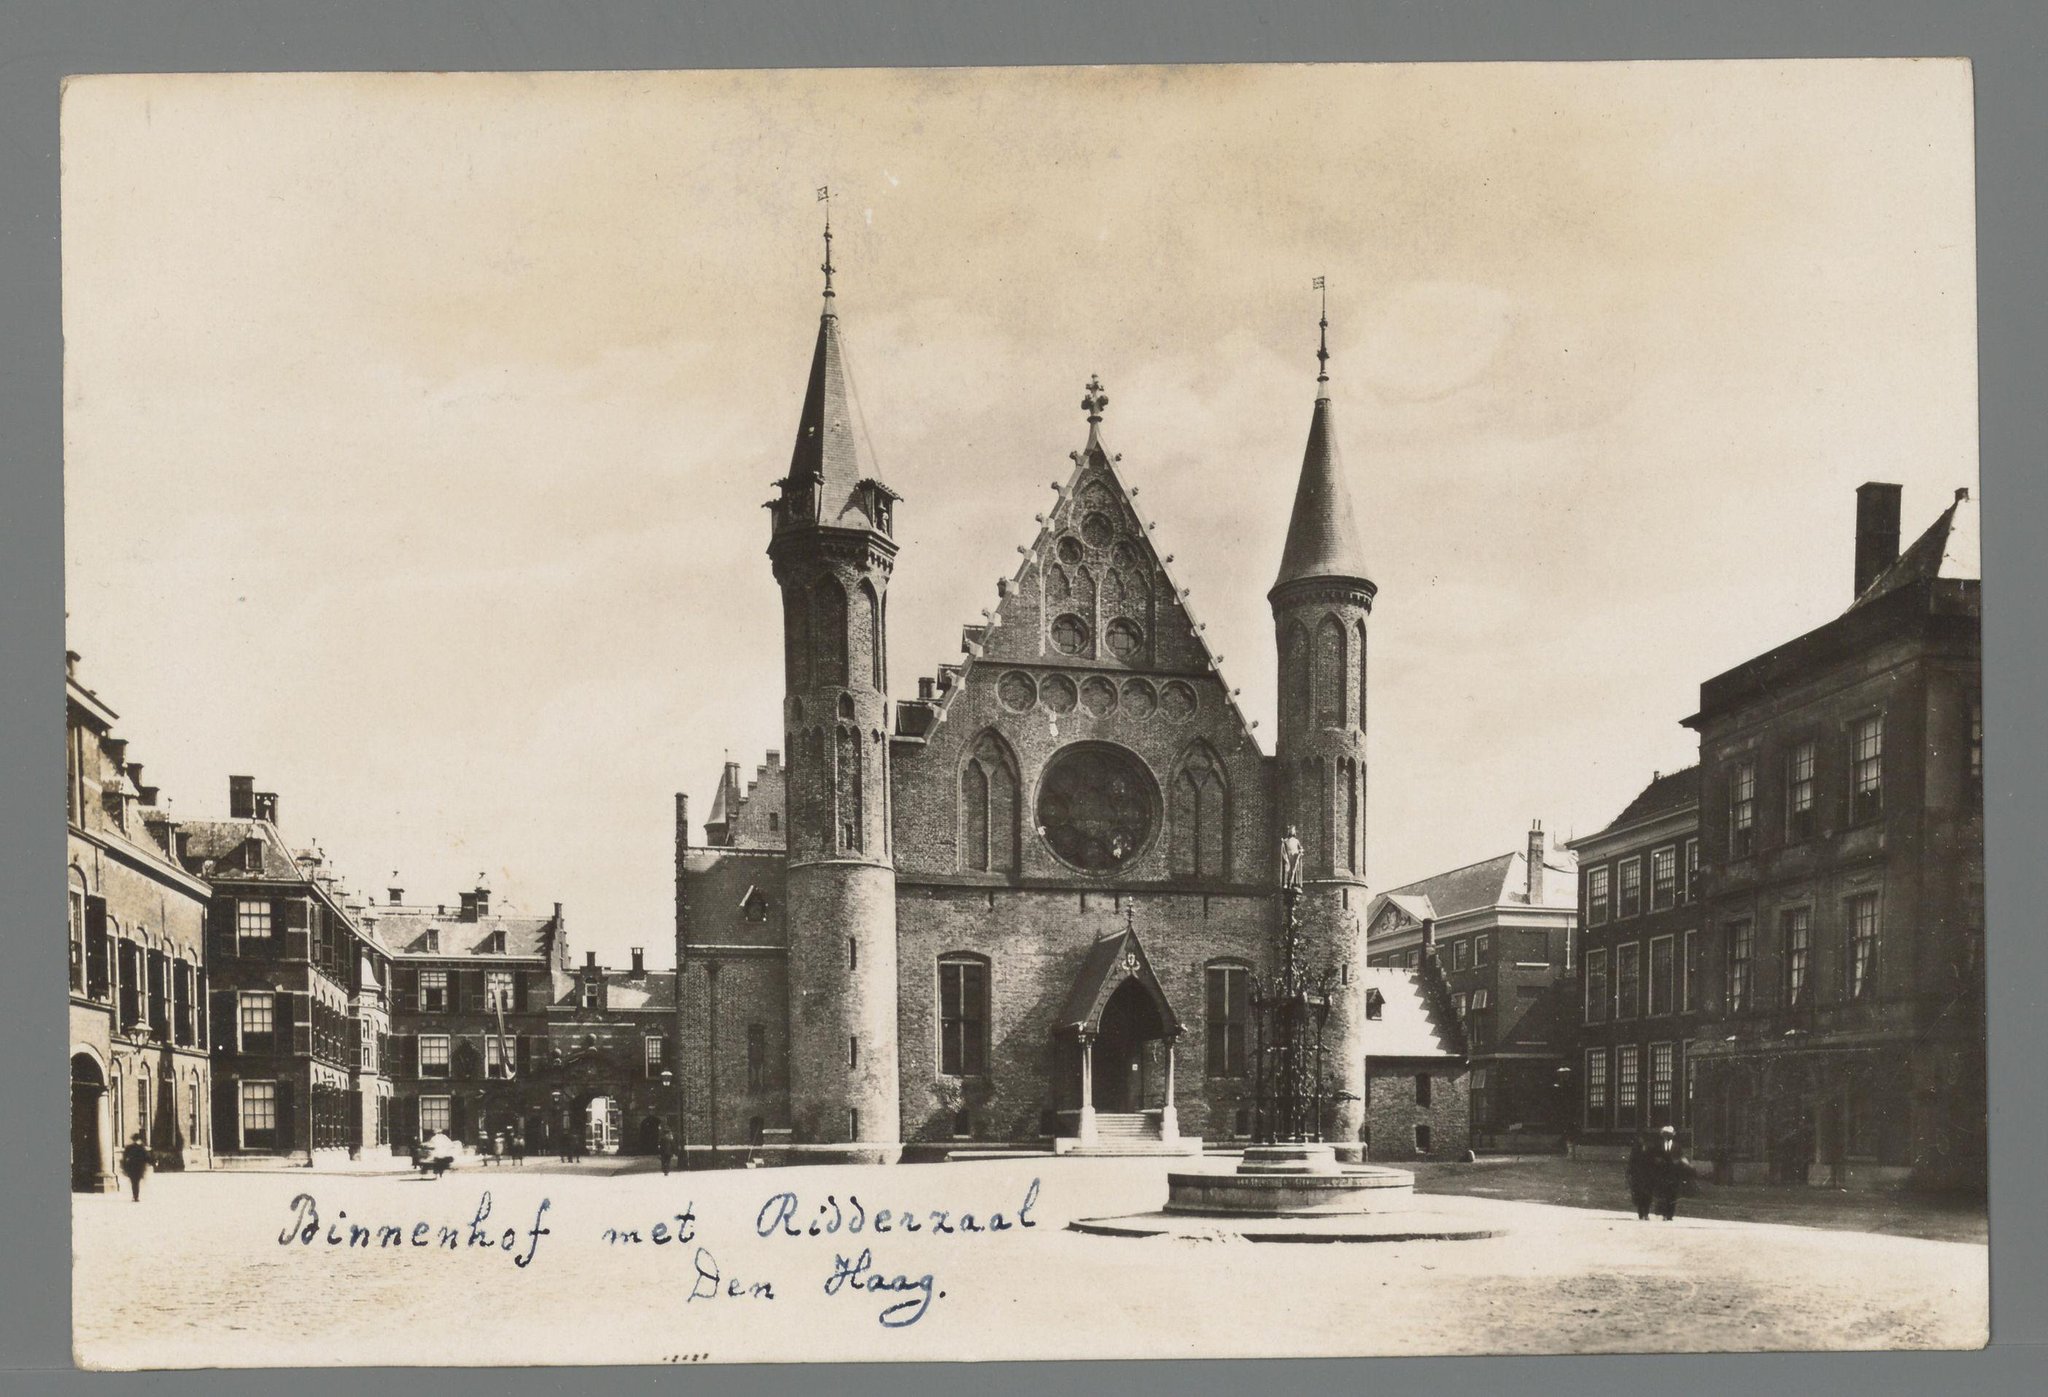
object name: photograph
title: Den Haag. Binnenhof met Ridderzaal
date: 1934-1941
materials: photographic support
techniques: gelatin silver print, writing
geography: the hague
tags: city-view, and landscape with man-made constructions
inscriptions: postage stamp